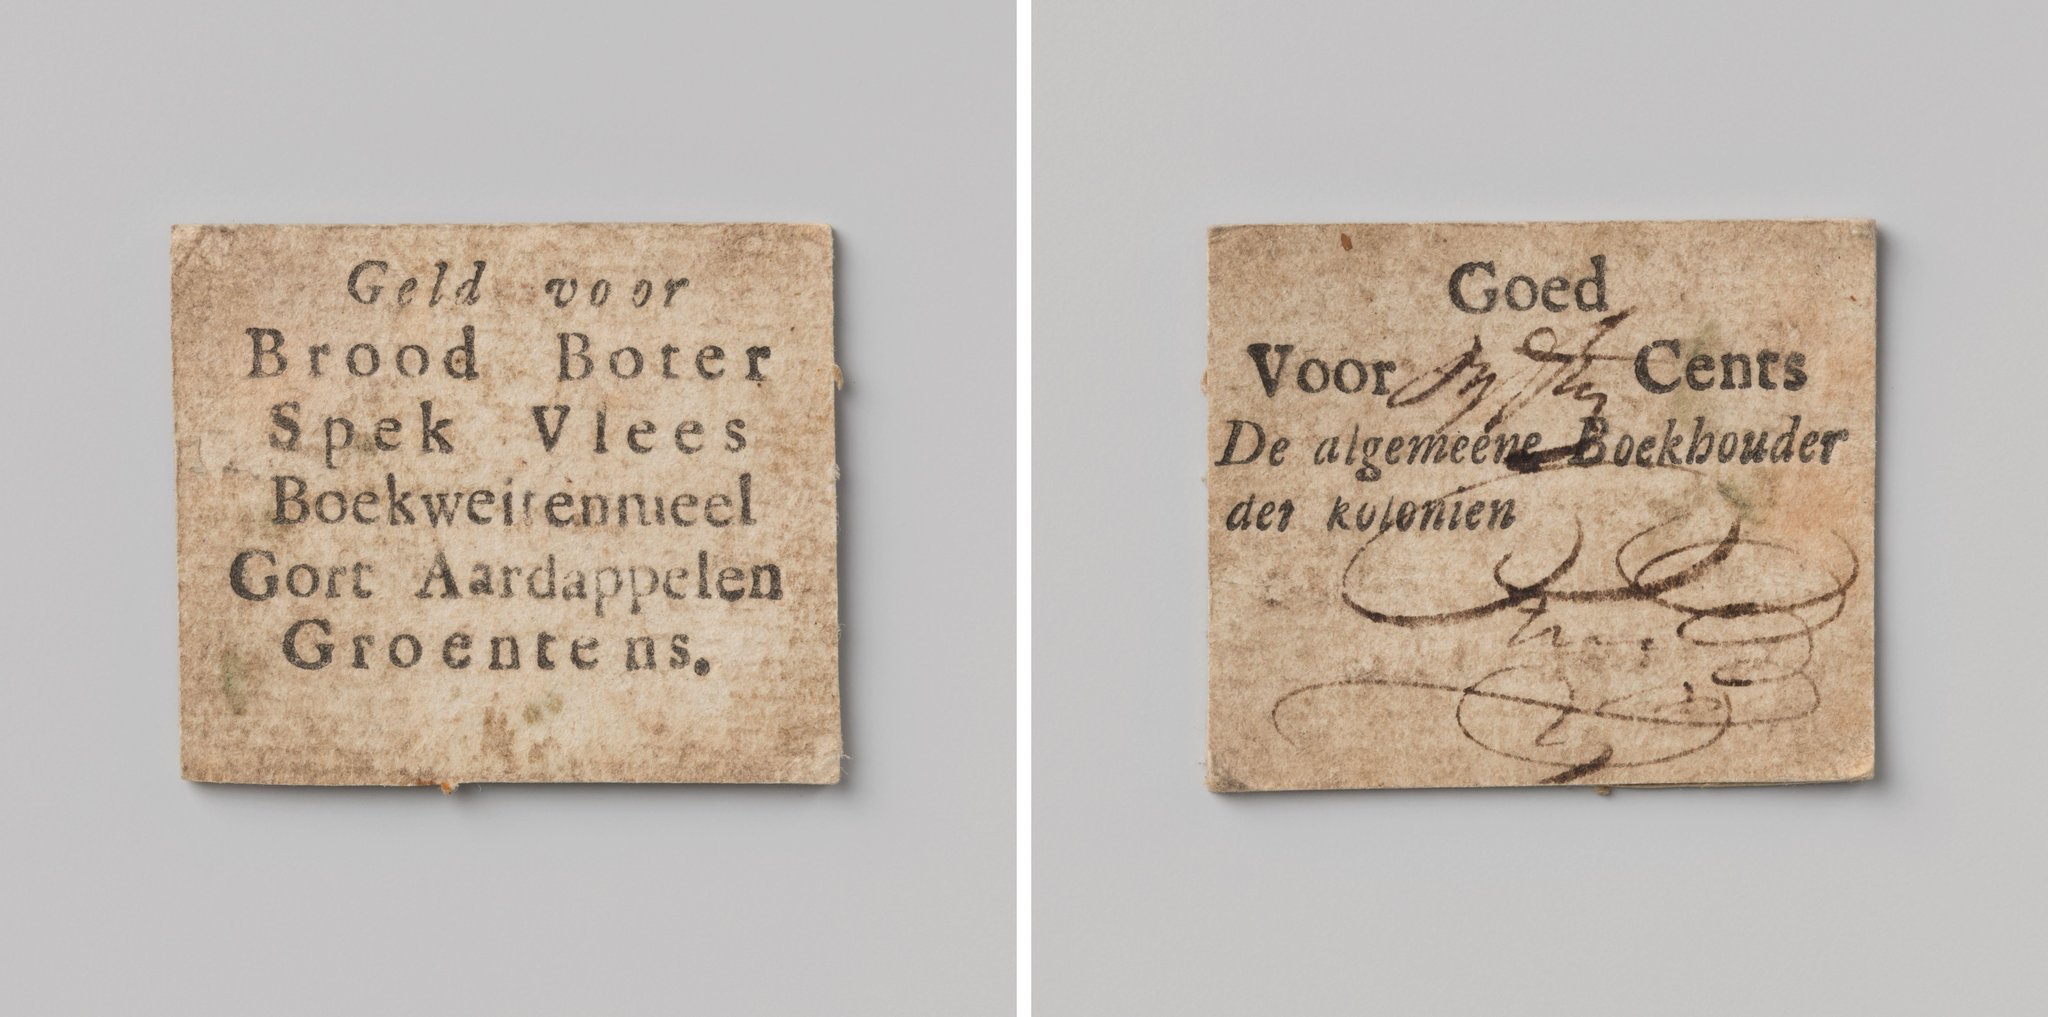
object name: waardepapier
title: Huismunt (winkelkaart) ter waarde van vijftien cent, uitgegeven door de algemene boekhouder der koloniën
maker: william reese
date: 1826-1830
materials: cardboard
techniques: printing, writing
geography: frederiksoord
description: Rechthoekige munt van wit karton. Voorzijde: opschrift: "Geld voor Brood Boter Spek Vlees Boekweitmeel Gort Aardappelen Groentens.". Keerzijde: opschrift in vier regels: "Goed Voor Cents De algemeene Boekhouder der kolonien"; daartussen met zwarte inkt ingevuld: waarde van munt en handtekening.